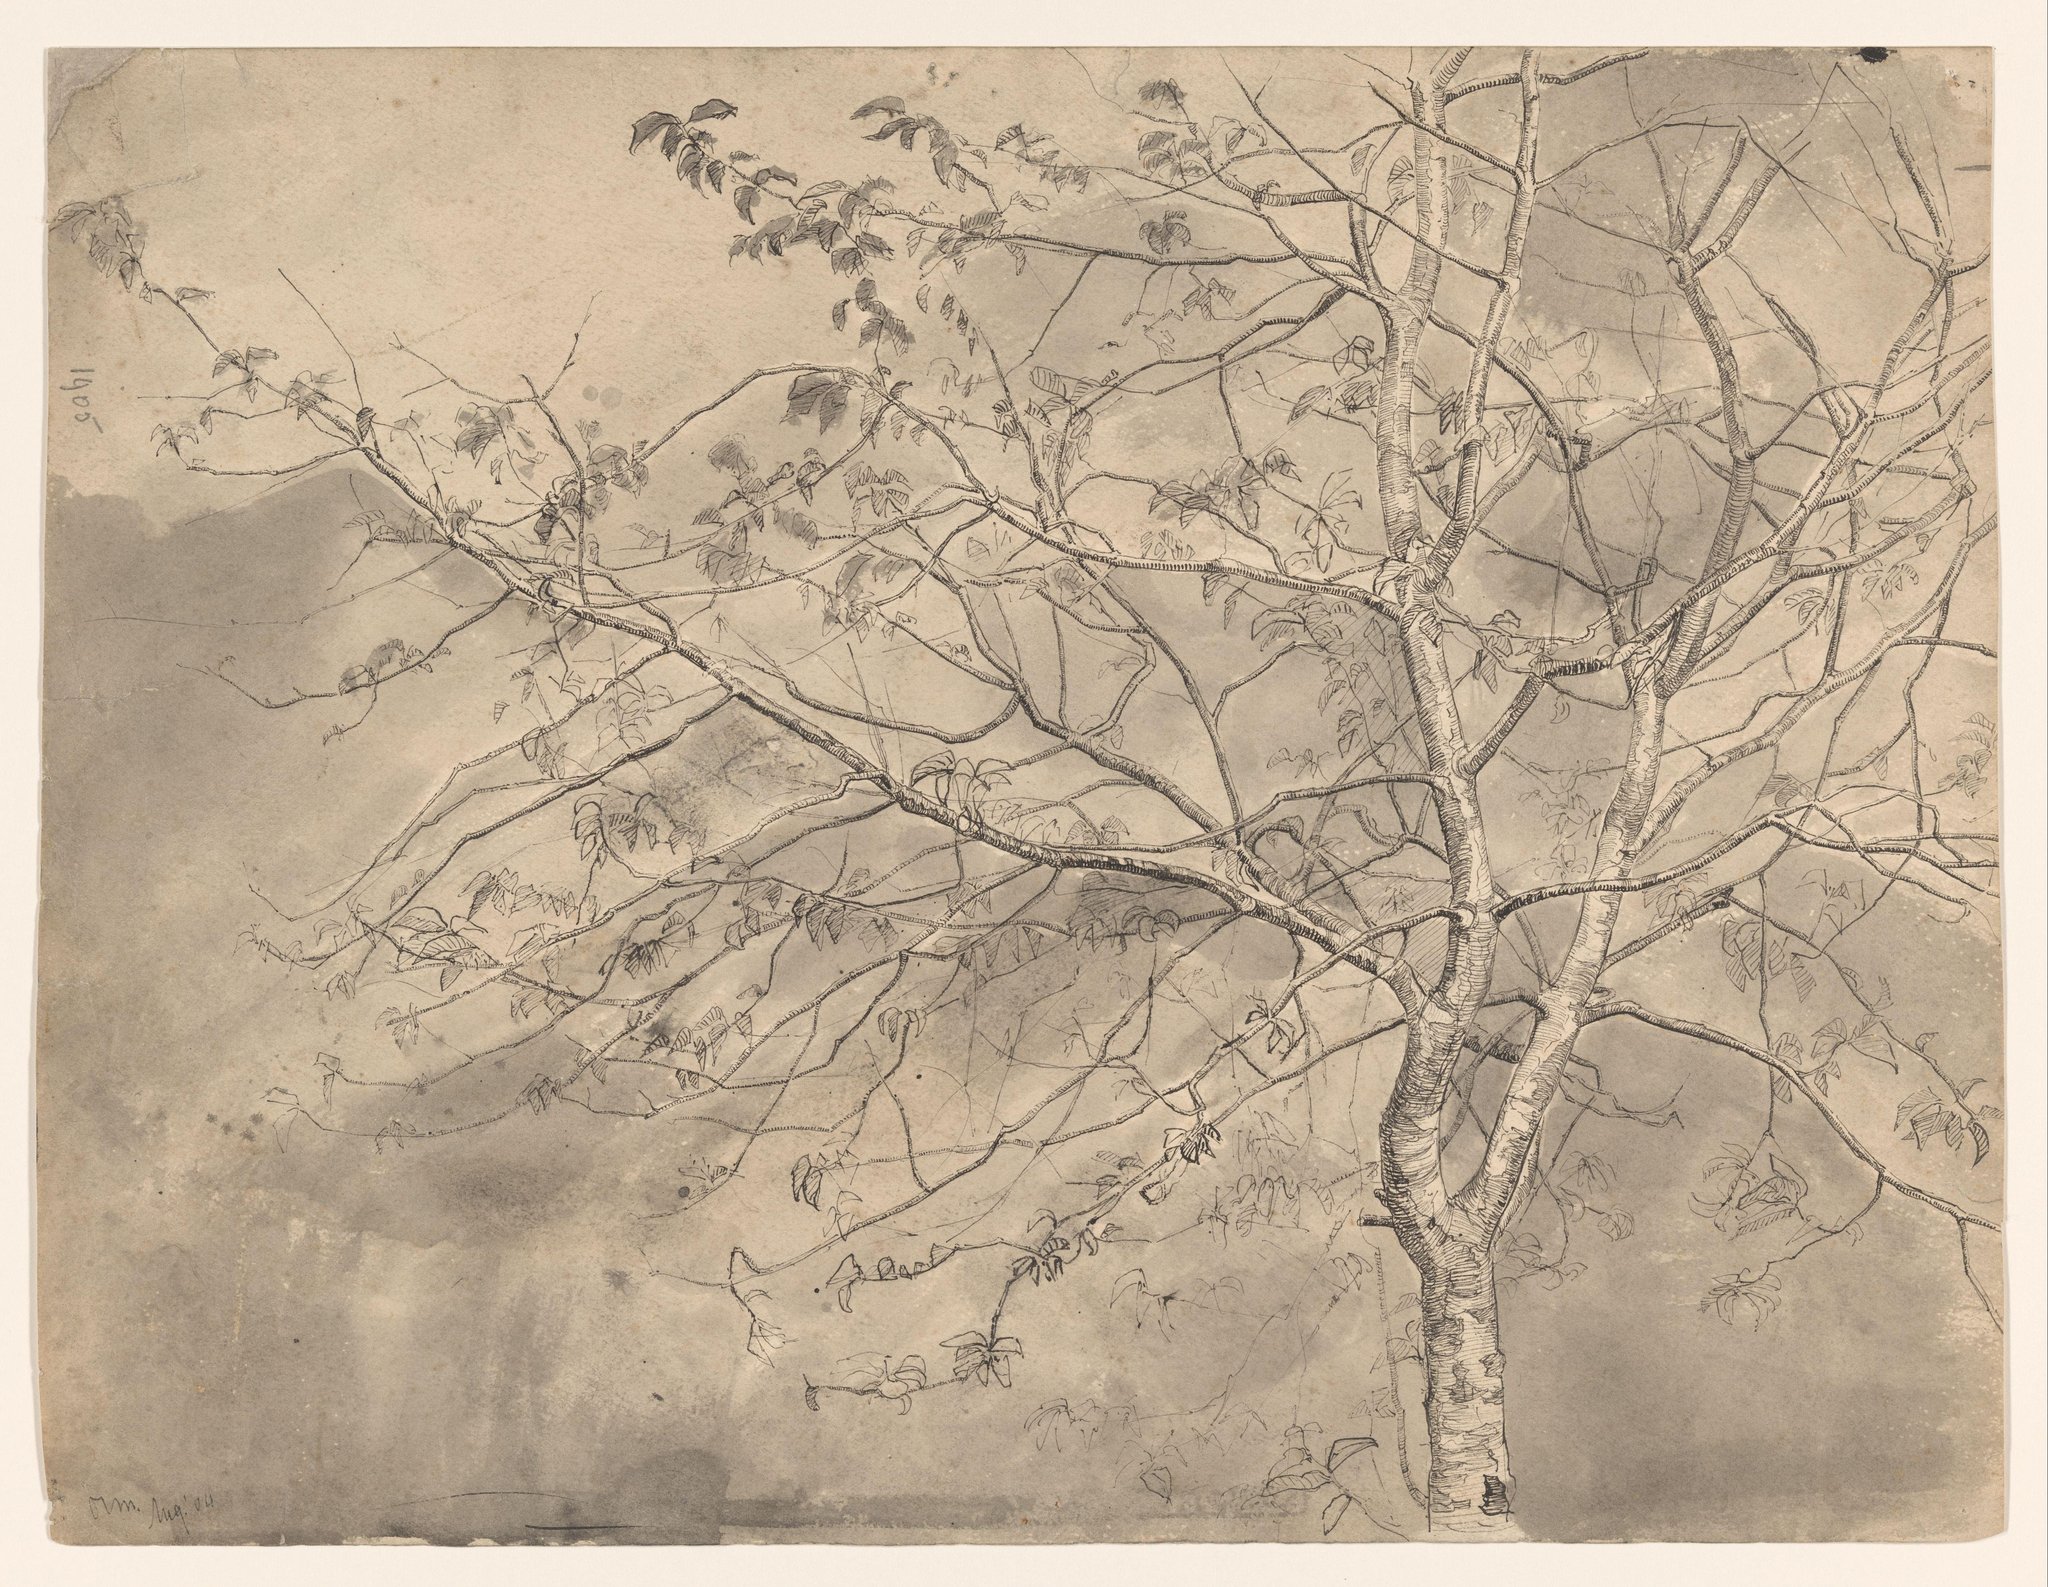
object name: drawing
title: Studie van een olm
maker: coba steenhoff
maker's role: draughtsman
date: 1904-1908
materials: ink, paper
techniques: brush, pen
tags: trees: elm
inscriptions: date: ‘aug '04’